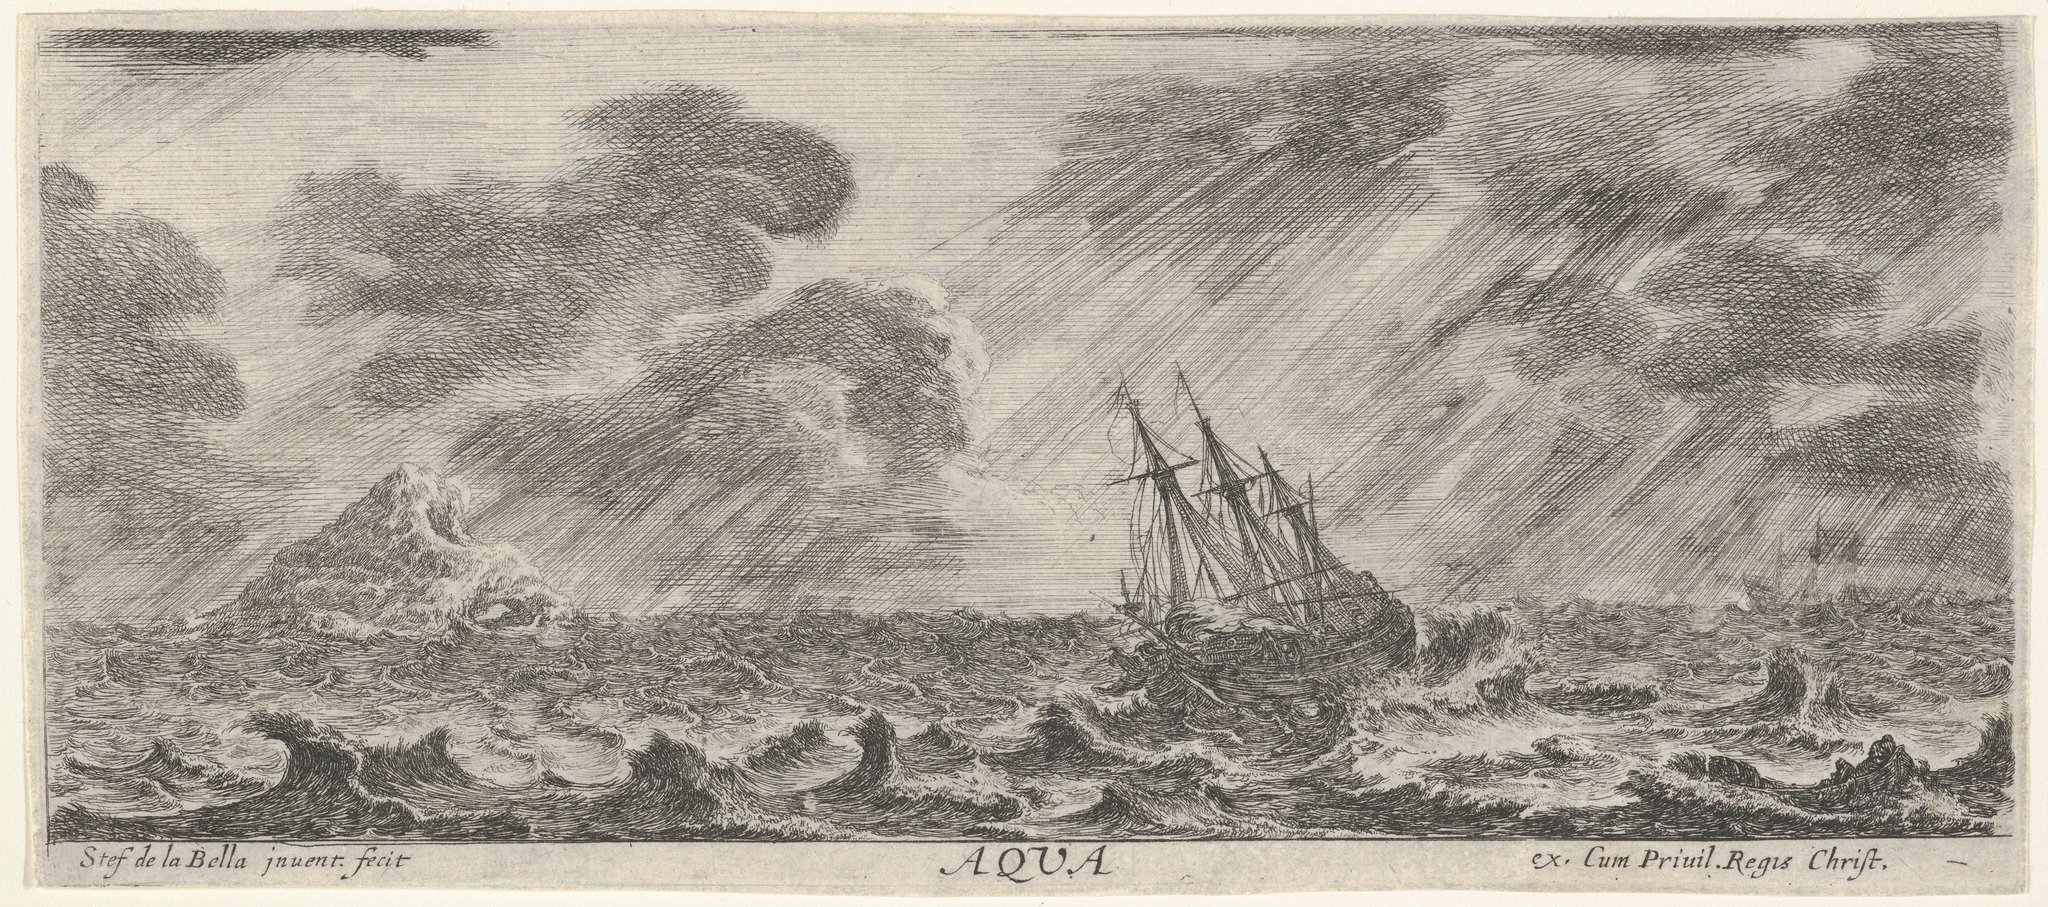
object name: print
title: Water, a ship at sea during a storm, from "The Four Elements" (Les Quatre Eléments)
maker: stefano della bella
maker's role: artist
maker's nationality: italian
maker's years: 1610-1664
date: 1645-1650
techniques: etching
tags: storms,ships